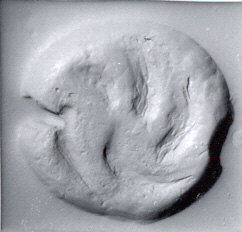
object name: stamp seal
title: Ovoid seal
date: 3500-3100 BCE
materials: stone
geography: iran or mesopotamia